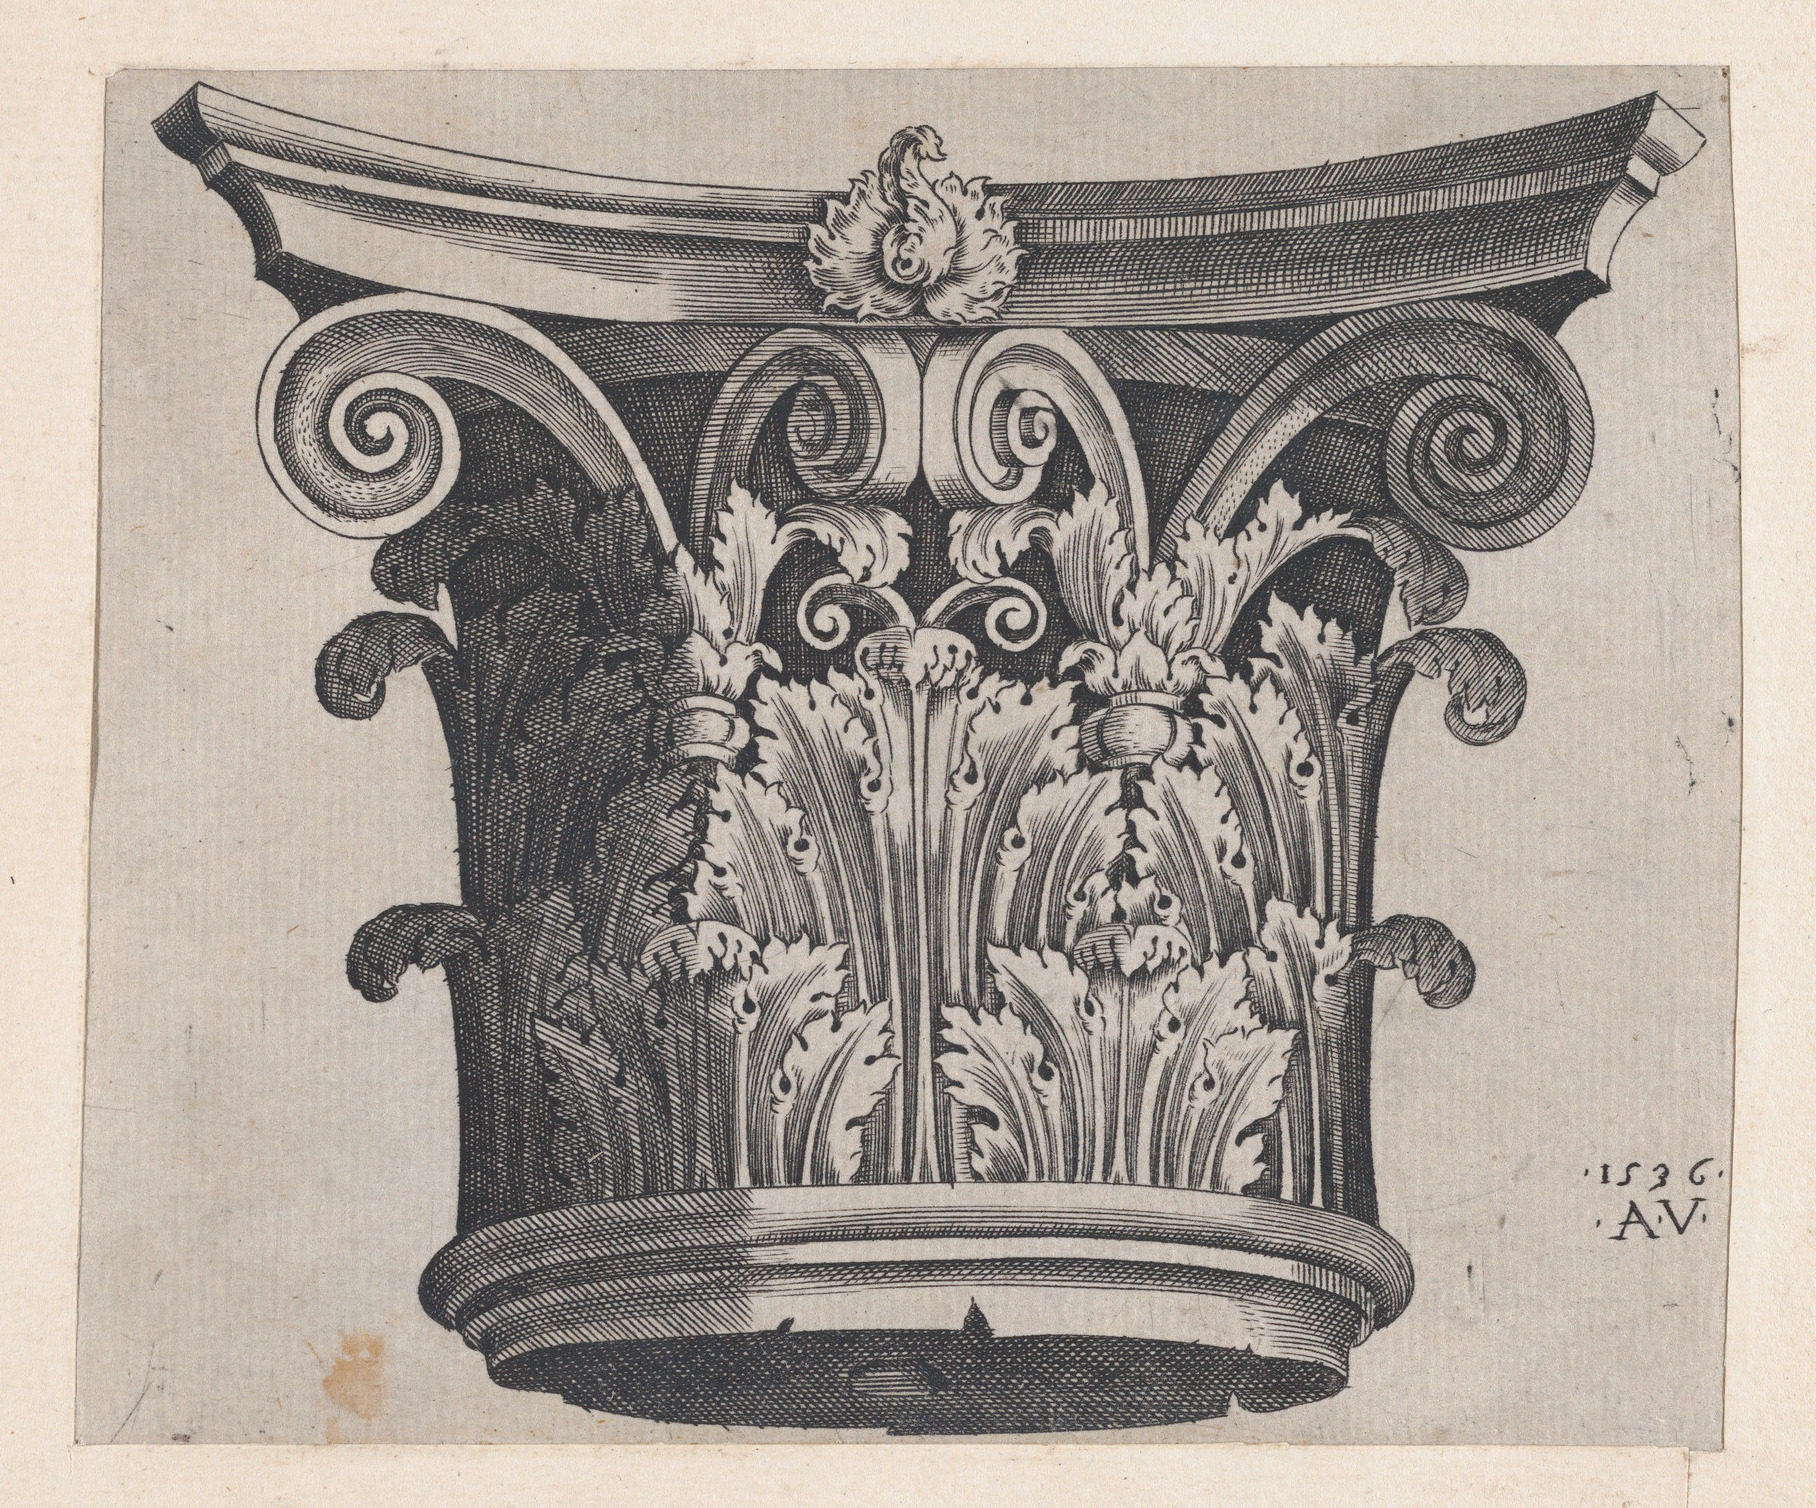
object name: print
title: Corinthian capital, from "Speculum Romanae Magnificentiae"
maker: agostino veneziano (agostino dei musi)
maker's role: artist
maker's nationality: italian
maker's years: 1490-1536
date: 1536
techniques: engraving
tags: capitals